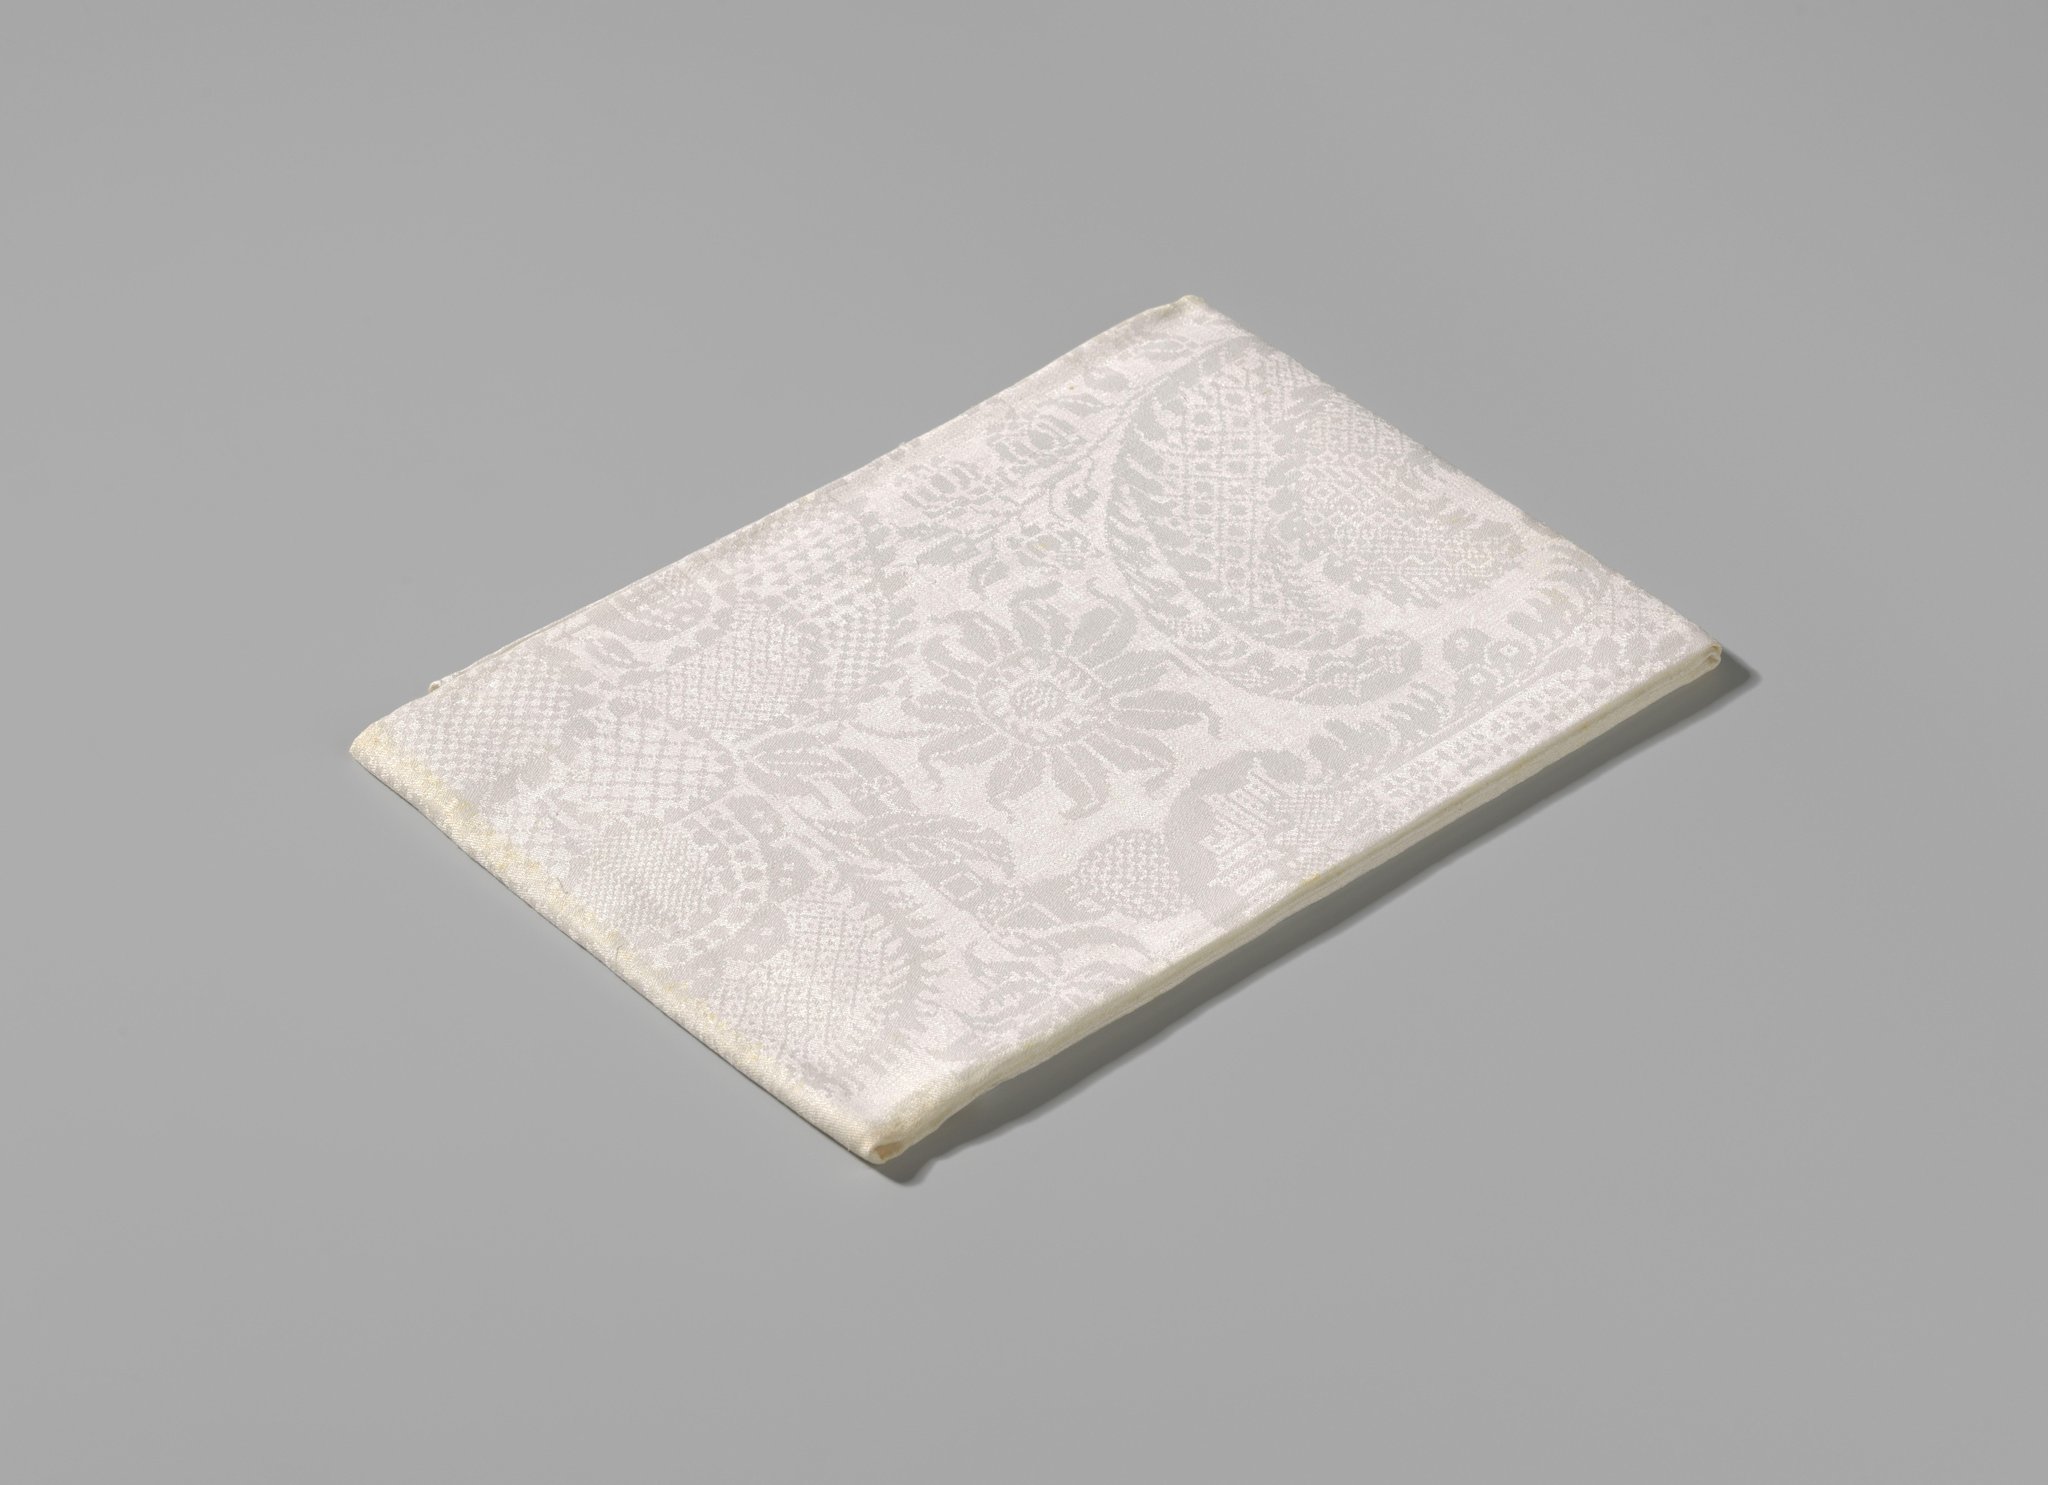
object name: napkin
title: Servet van linnendamast met een kantpatroon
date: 1725-1735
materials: linen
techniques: damask, weave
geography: flanders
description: Servet van linnendamast met een kantpatroon. Bij het servet hoort een servet met invnr. BK-1980-104-B en een tafellaken (BK-1980-103). Het servet is gemerkt: gekroonde letters VE 26.